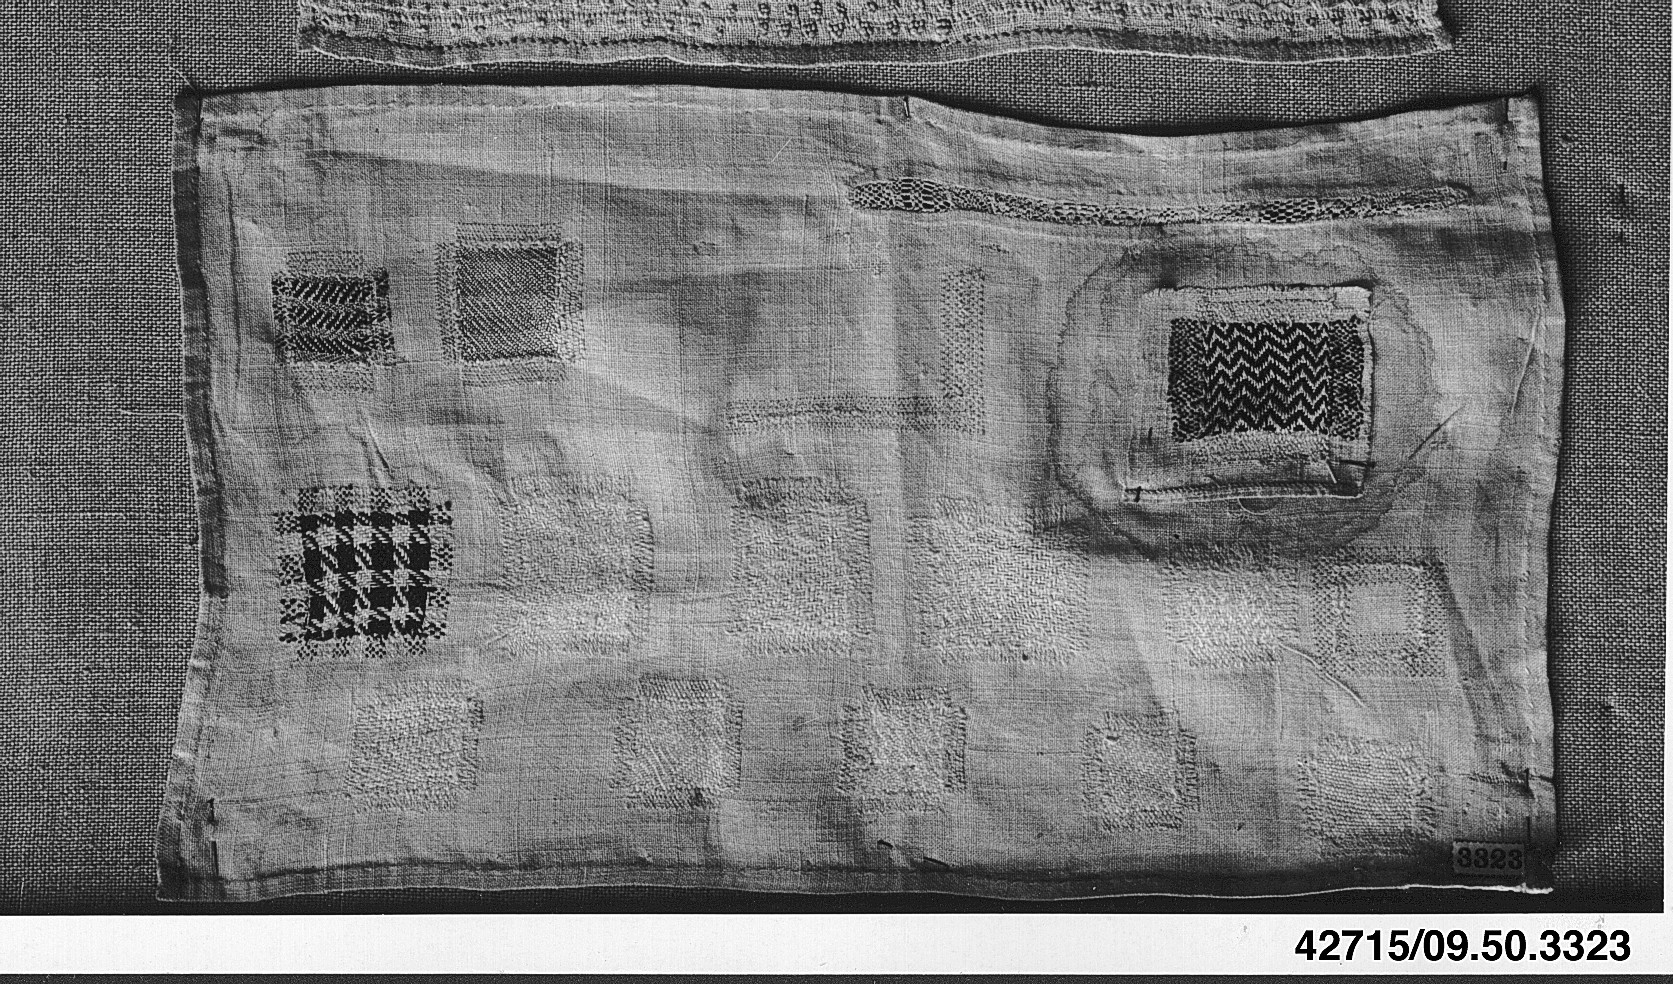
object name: sampler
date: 1767-1800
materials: linen, silk